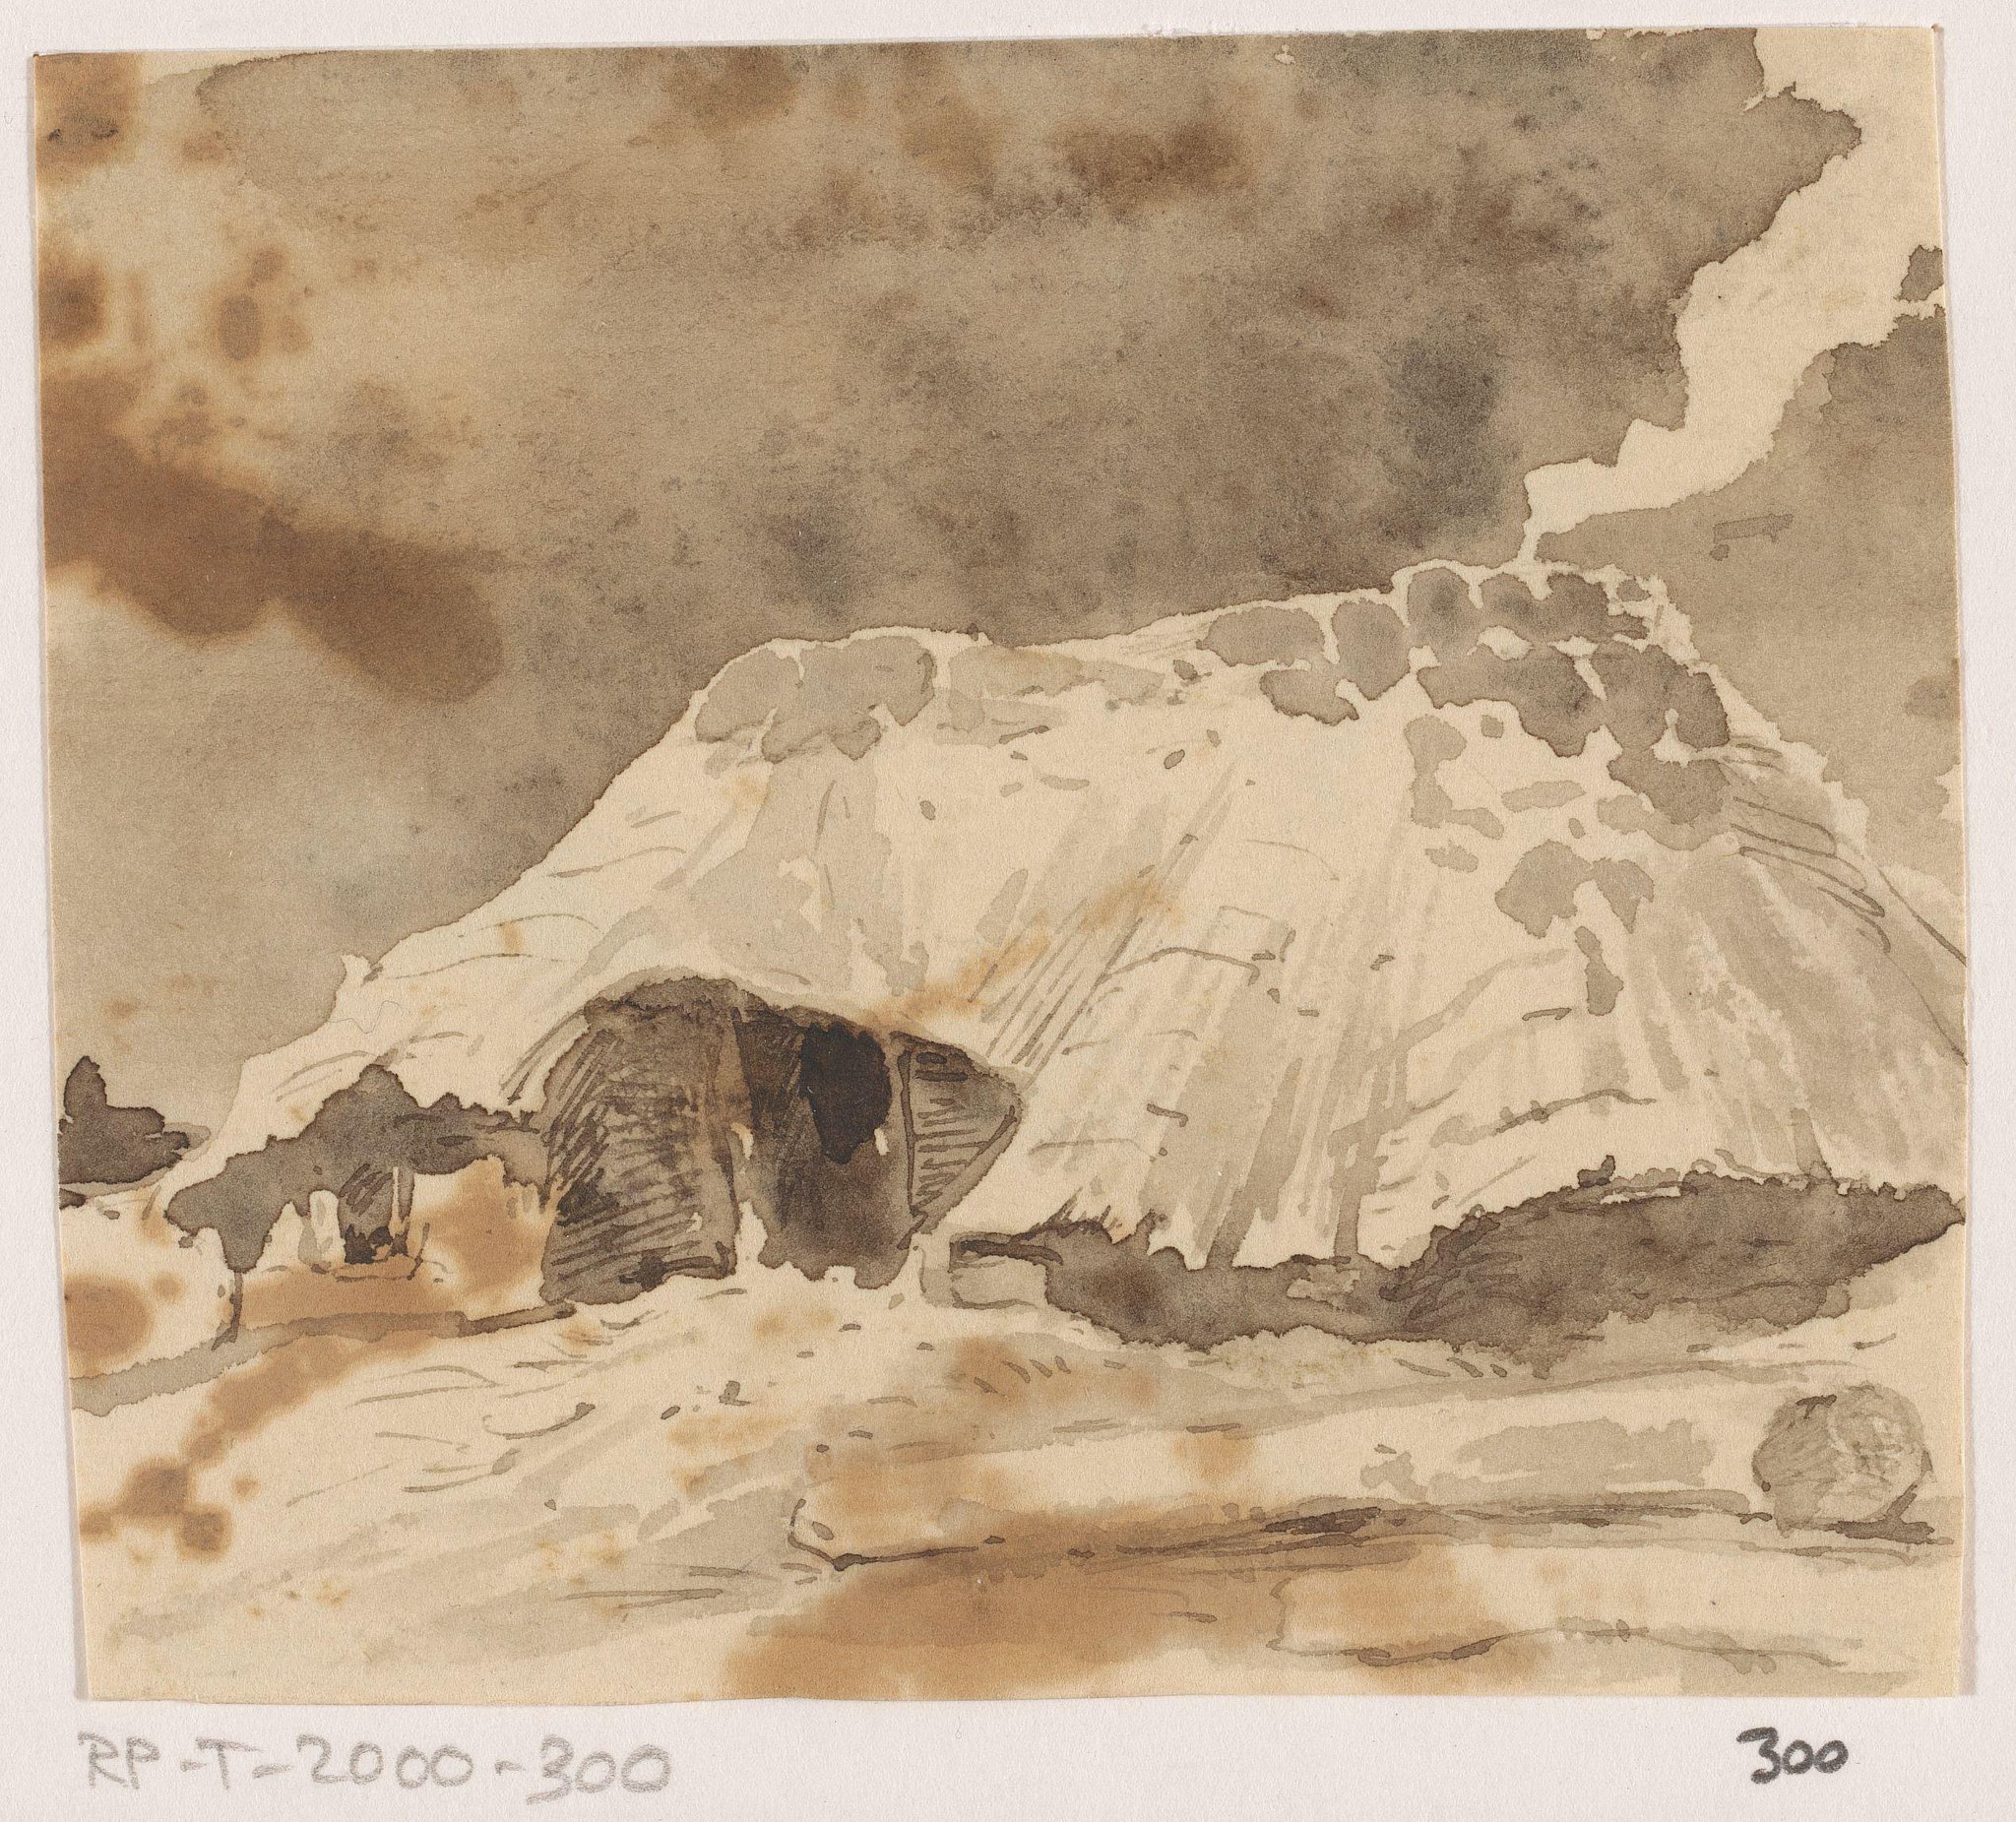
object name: drawing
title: Huis met rook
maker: johannes tavenraat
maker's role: draughtsman, painter, print maker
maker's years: 1809-1881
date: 1840-1880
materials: ink, paper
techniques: brush, pen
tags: cottage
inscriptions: collector's mark: Lugt 2228, signature: ‘Tavenraat’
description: Huis met laag rieten dak, met rook uit de schoorsteen.